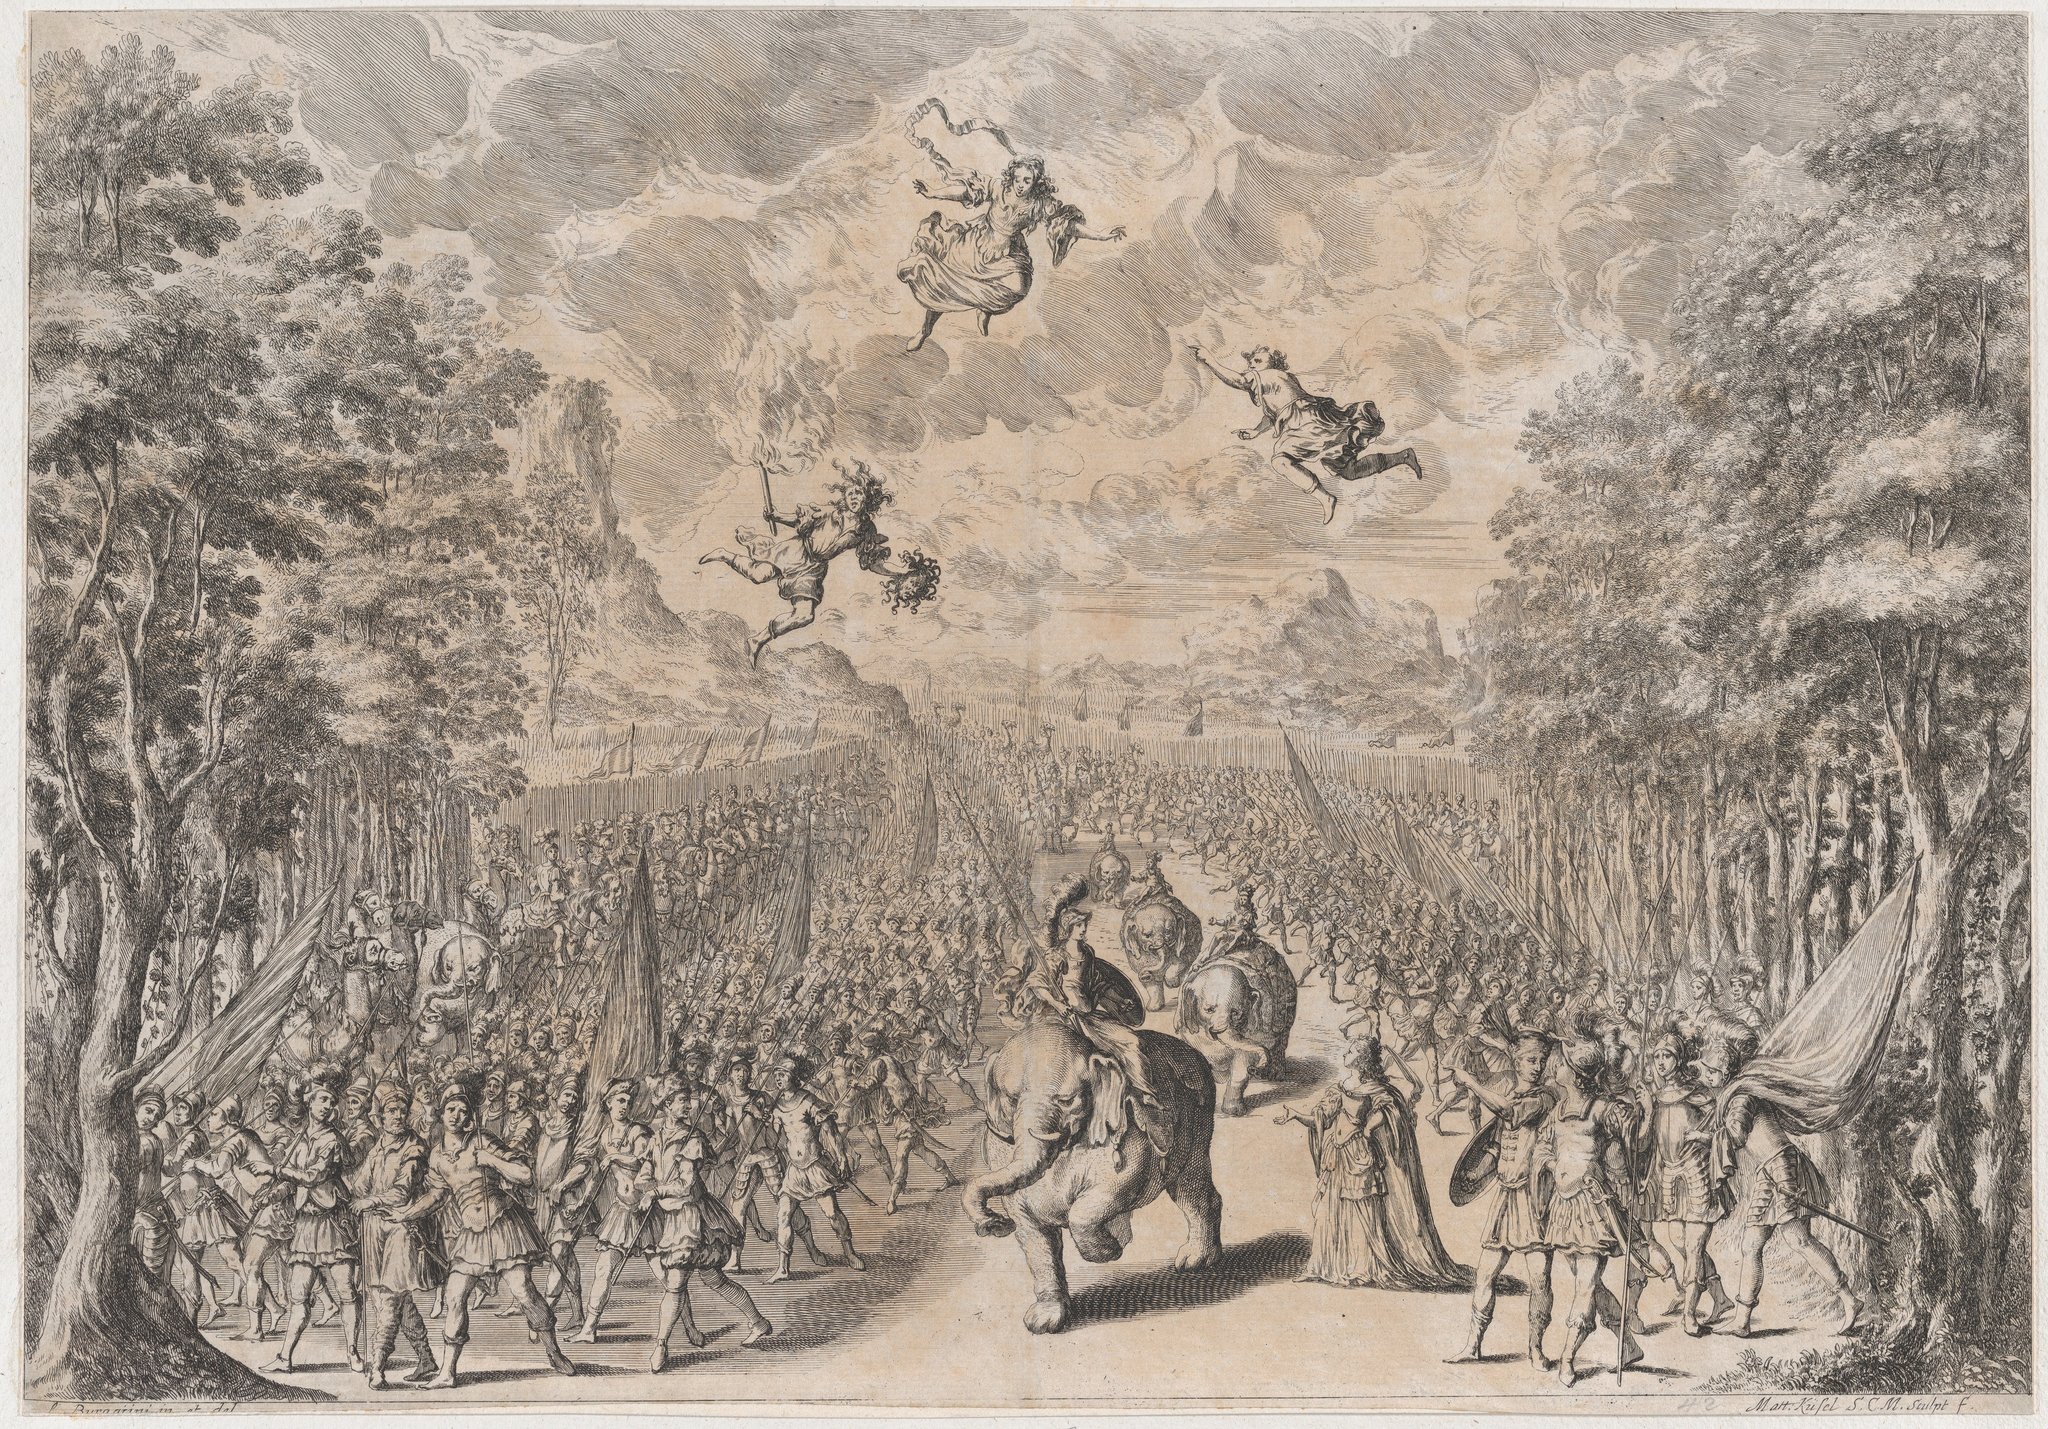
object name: print, fete, ornament architecture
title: An army marching through a field; soldiers on foot at left and right, while others ride elephants and camels down the center; set design from 'La Monarchia Latina Trionfante'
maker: mathäus küsel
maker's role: artist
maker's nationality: german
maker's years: 1621-1682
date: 1678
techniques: etching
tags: army,camels,elephants,horses,stage design